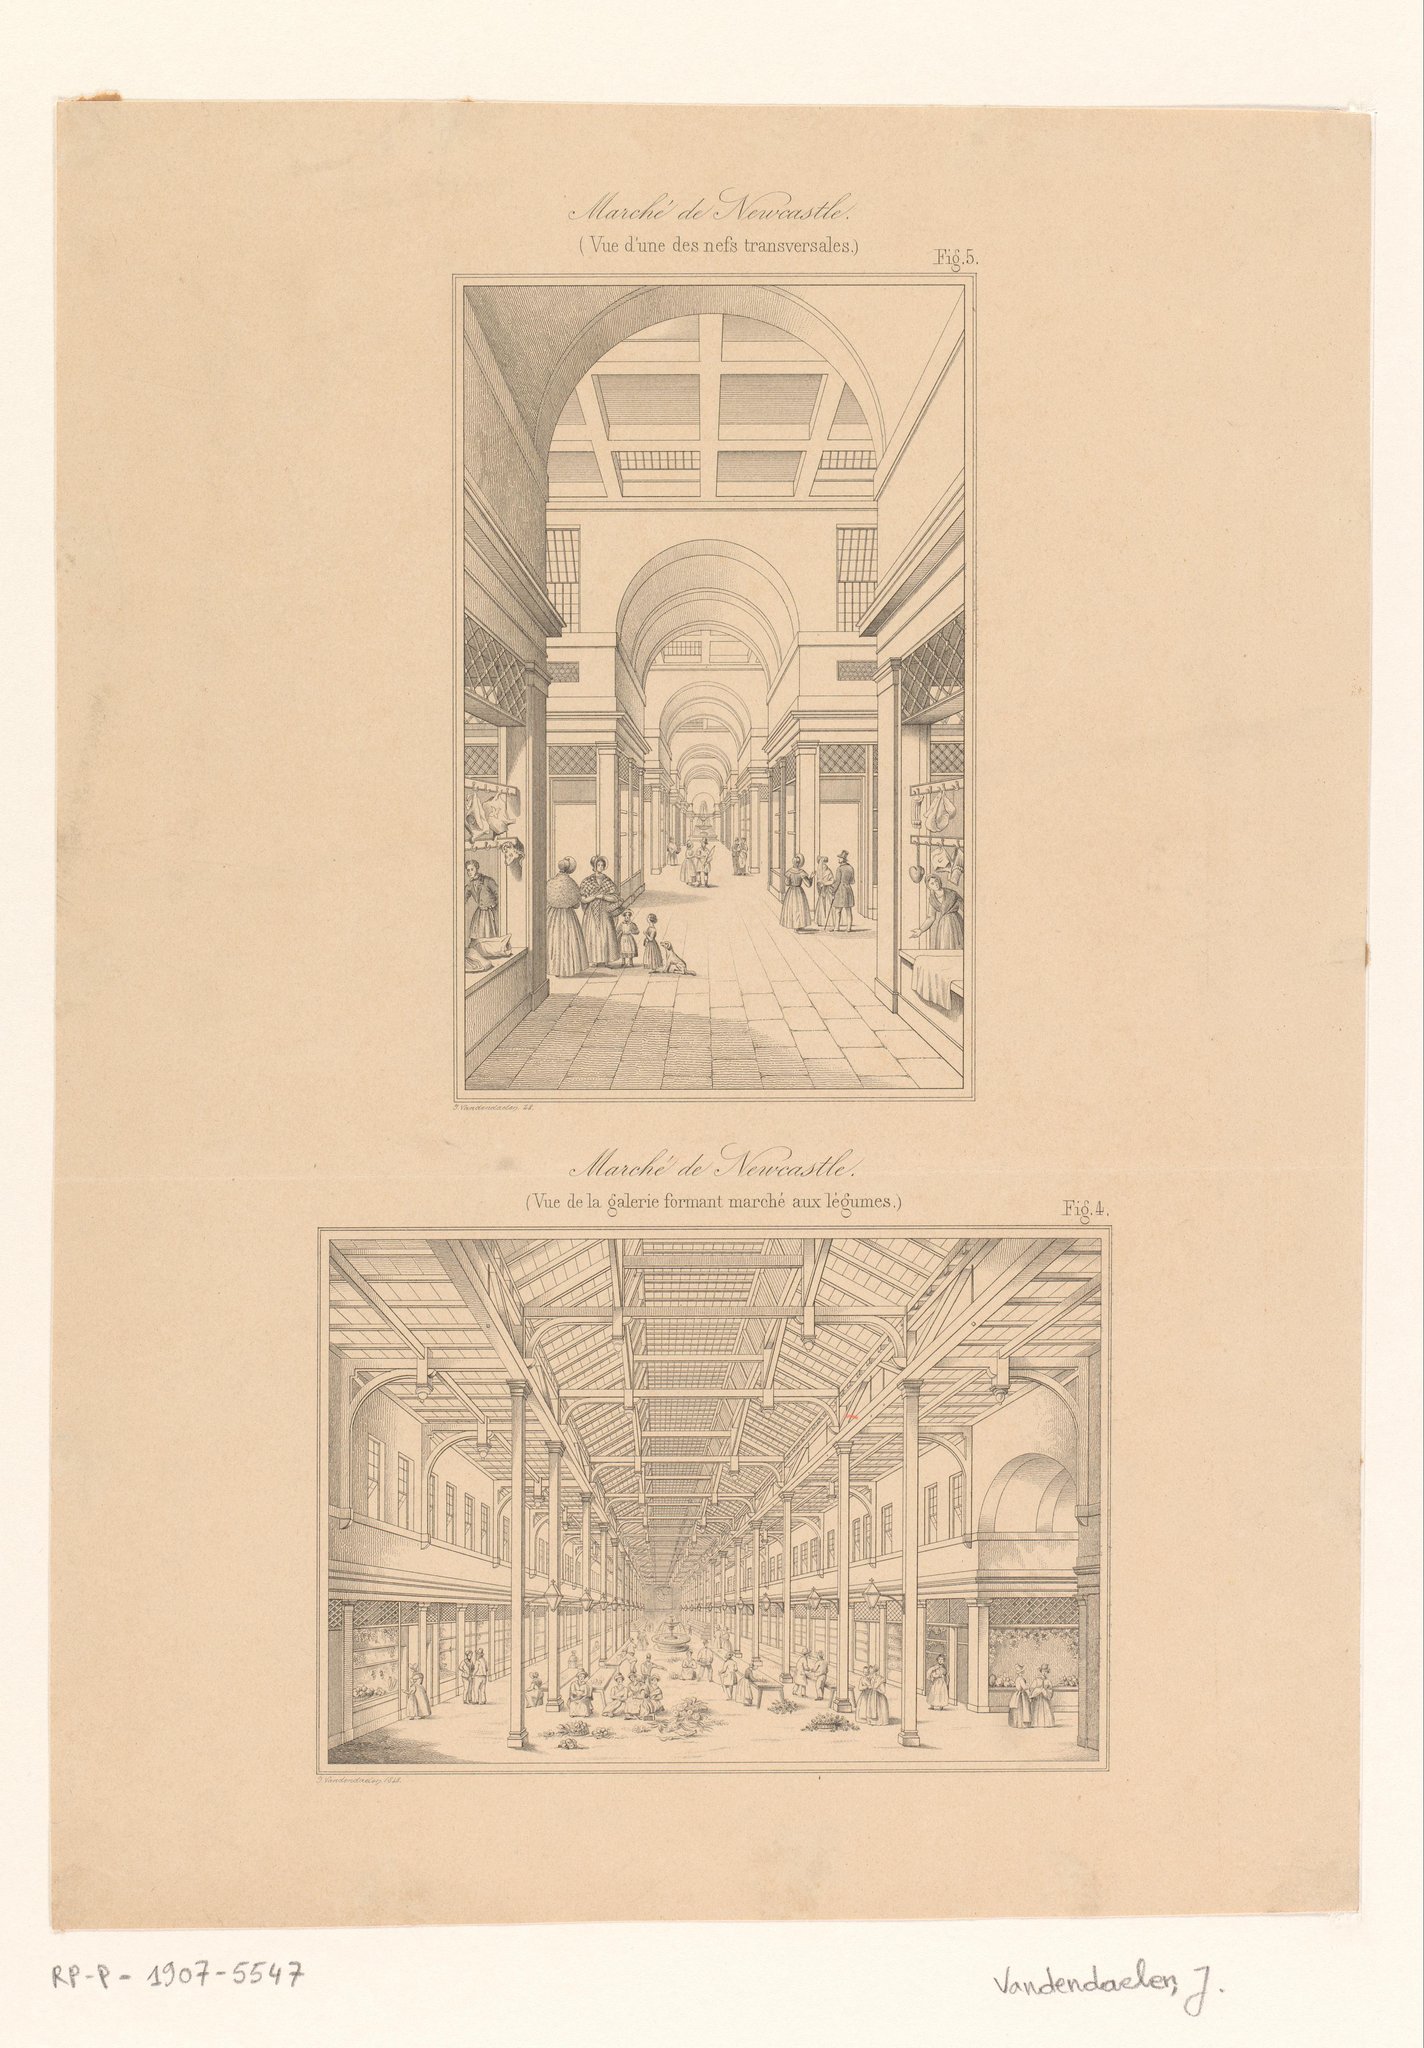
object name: print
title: Marché de Newcastle (vue d'une des nefs transversales)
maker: j. vandendaelen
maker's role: print maker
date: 1848-1907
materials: paper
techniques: lithograph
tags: market-hall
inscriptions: collector's mark: Lugt 2228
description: Bovenste voorstelling is genummerd: Fig. 5. De onderste voorstelling is genummerd: Fig. 4.